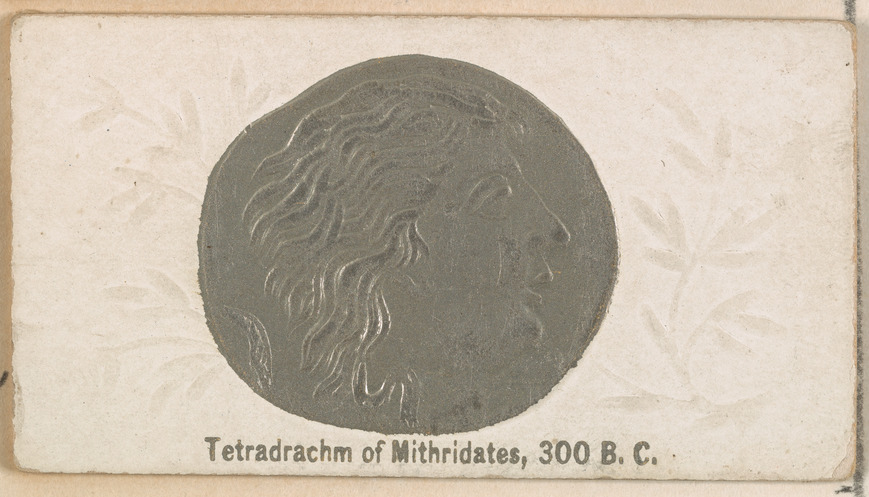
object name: print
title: Tetradrachm of Mithridates, 300 B.C., from the Ancient Coins series (N180) issued by Wm. S. Kimball & Co.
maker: william s. kimball & company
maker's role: publisher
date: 1888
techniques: color lithograph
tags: coins